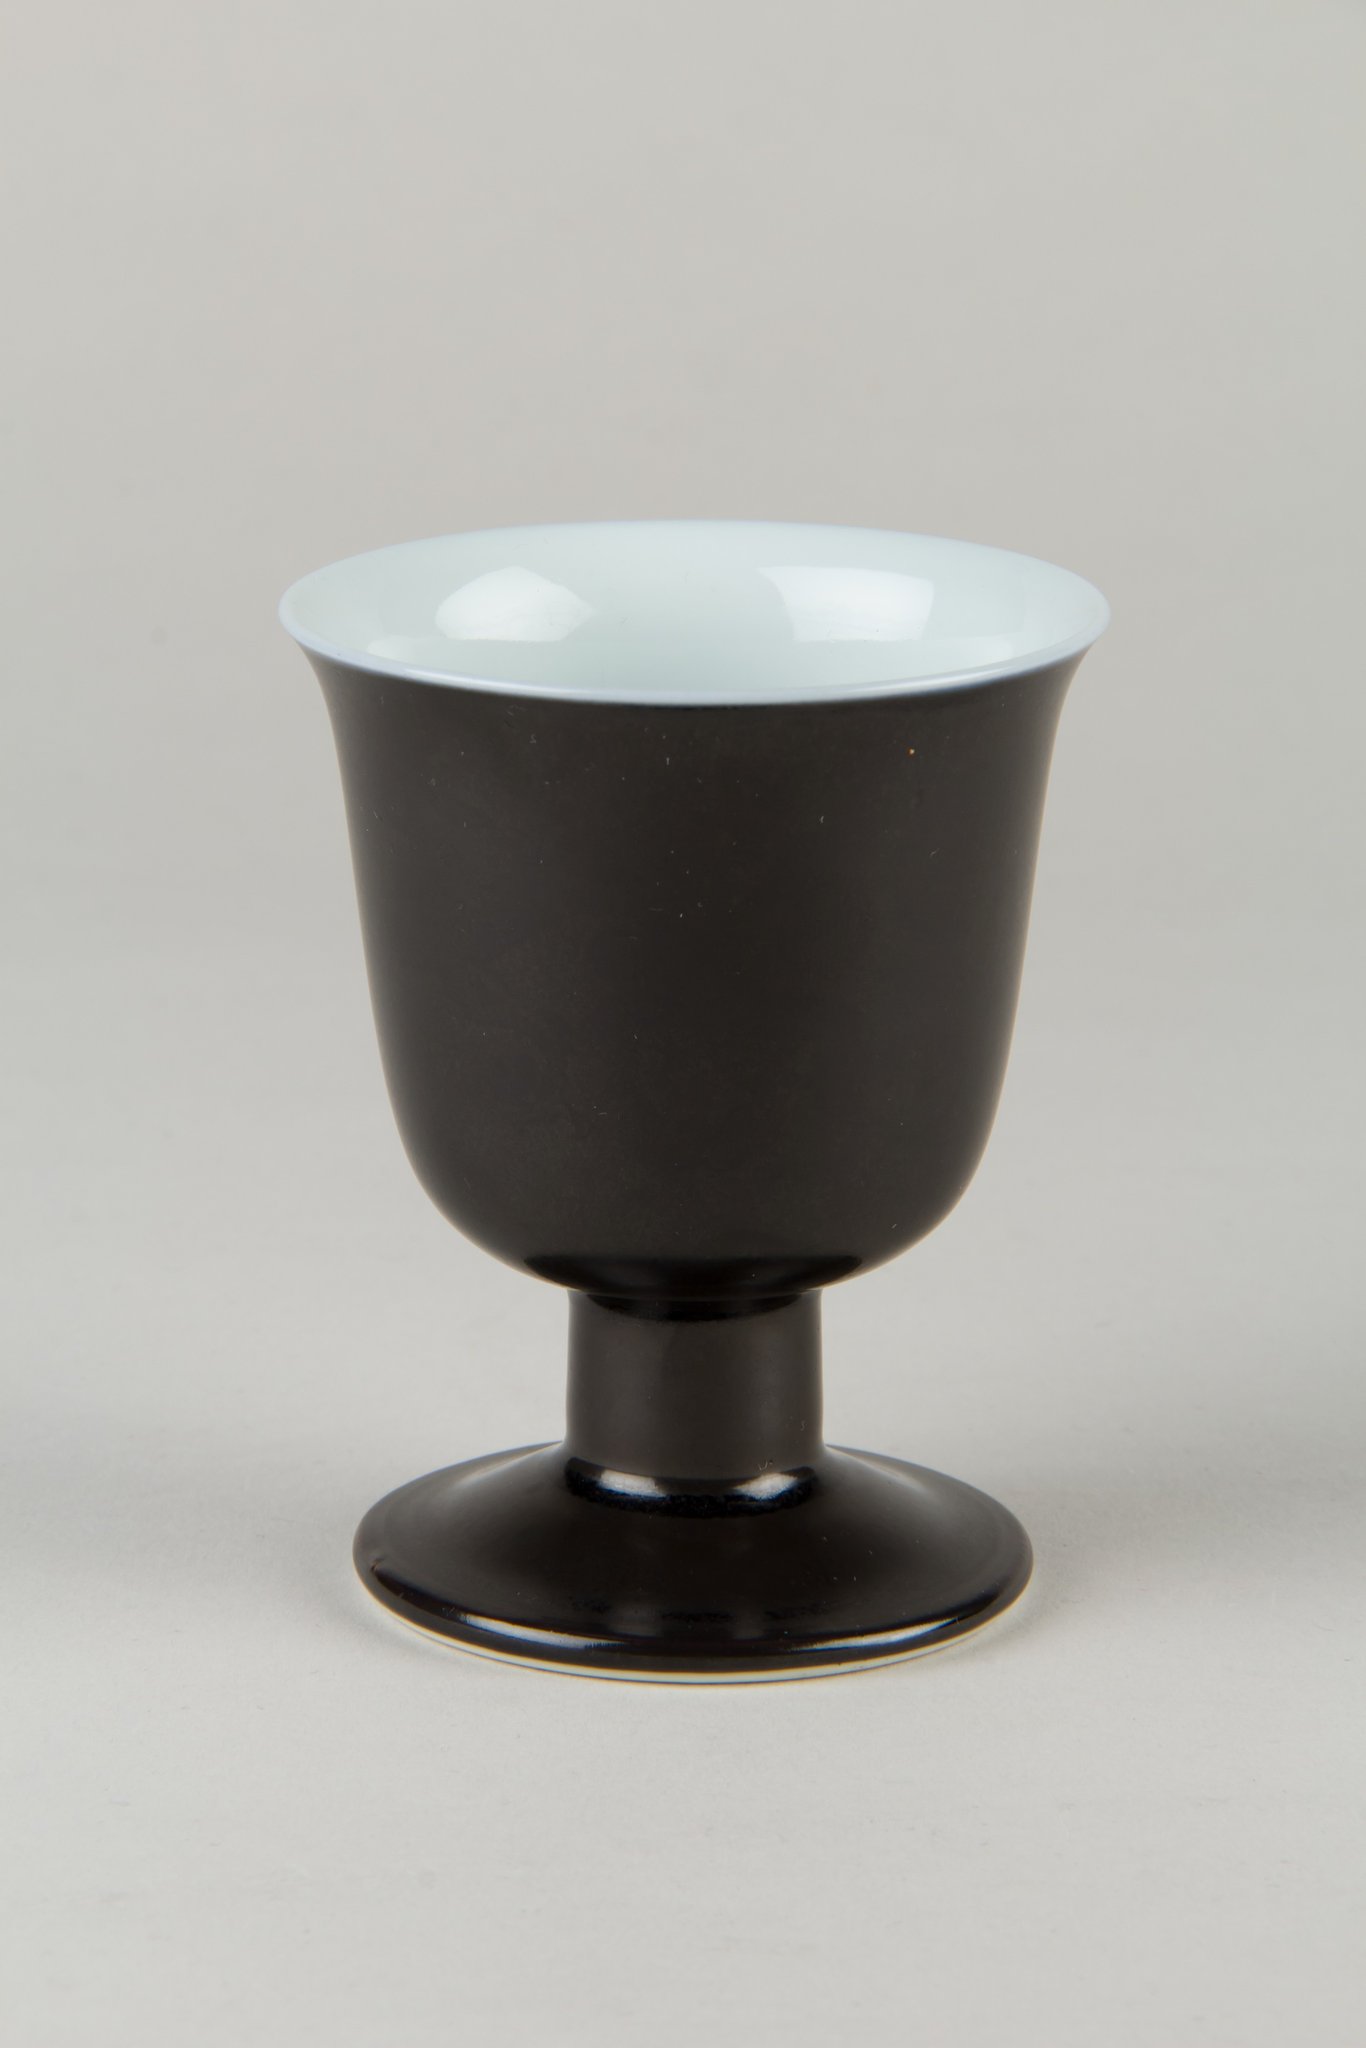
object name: stem cup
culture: chinese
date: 1723-1735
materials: gilt, glaze, porcelain